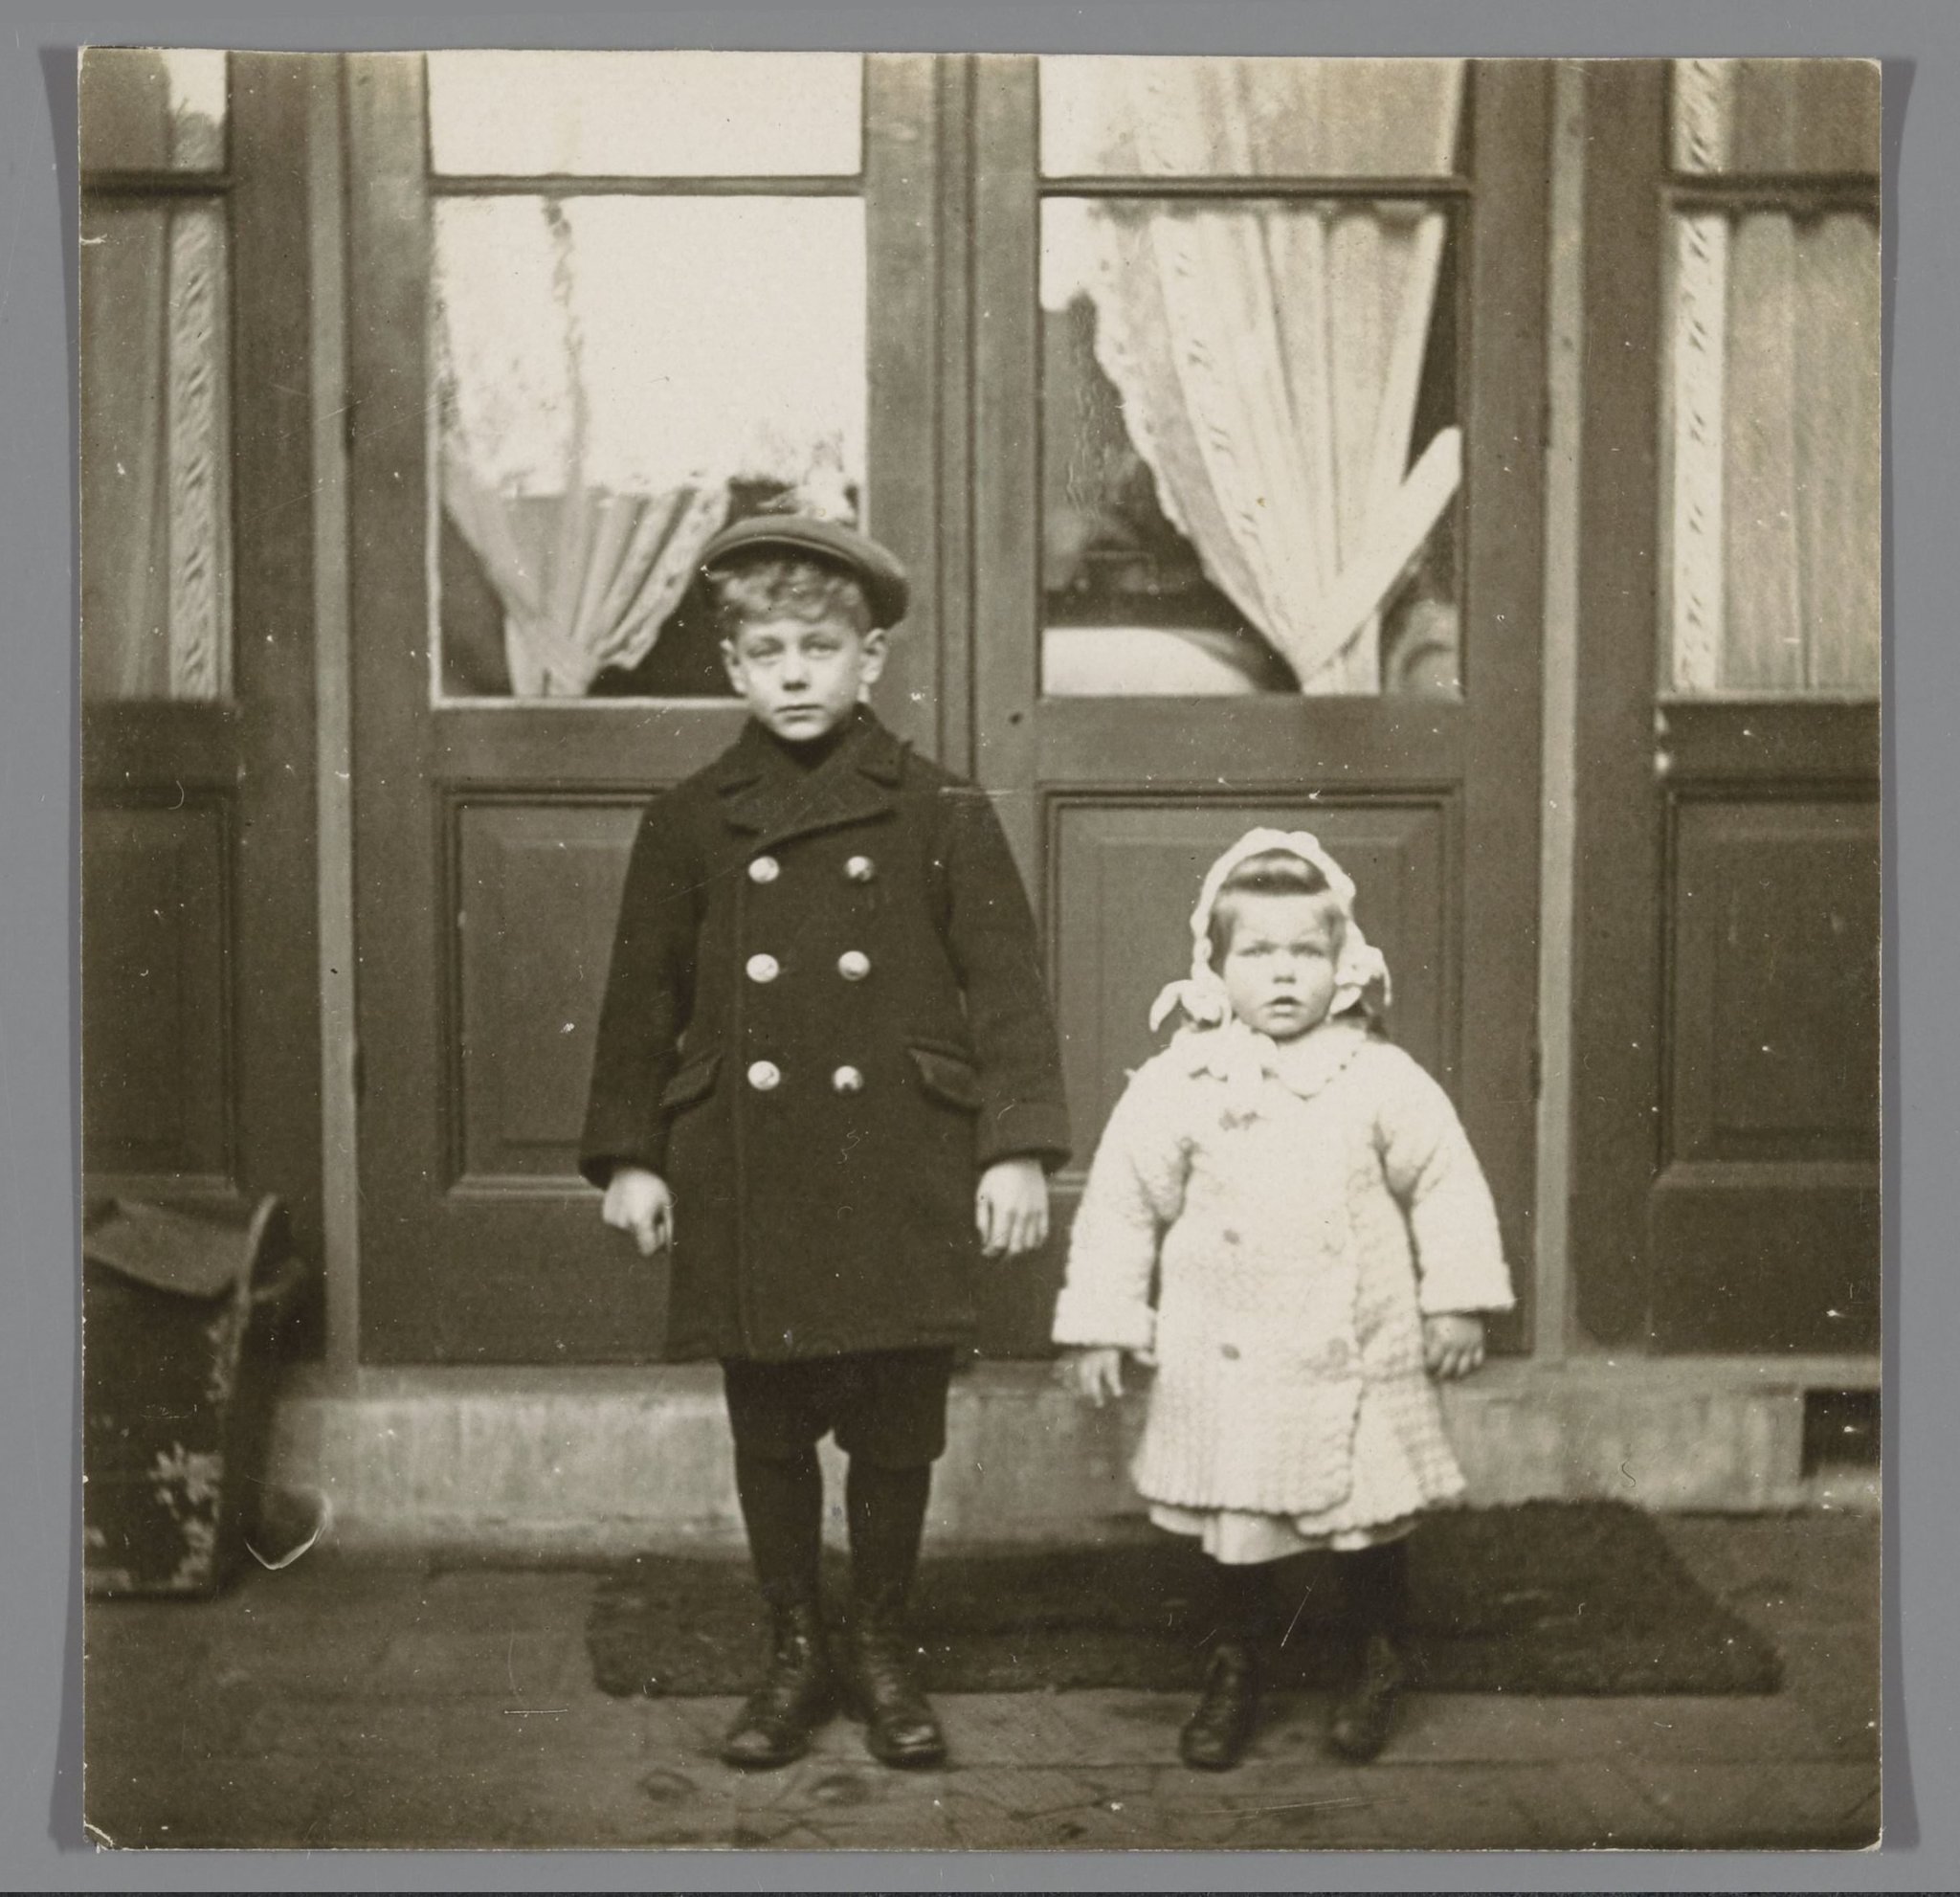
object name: photograph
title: Portret van twee onbekende kinderen, staande voor een deur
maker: Anonymous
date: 1905-1910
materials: paper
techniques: gelatin silver print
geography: netherlands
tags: toddler, boy (child between toddler and youth), anonymous historical persons portrayed in a double portrait